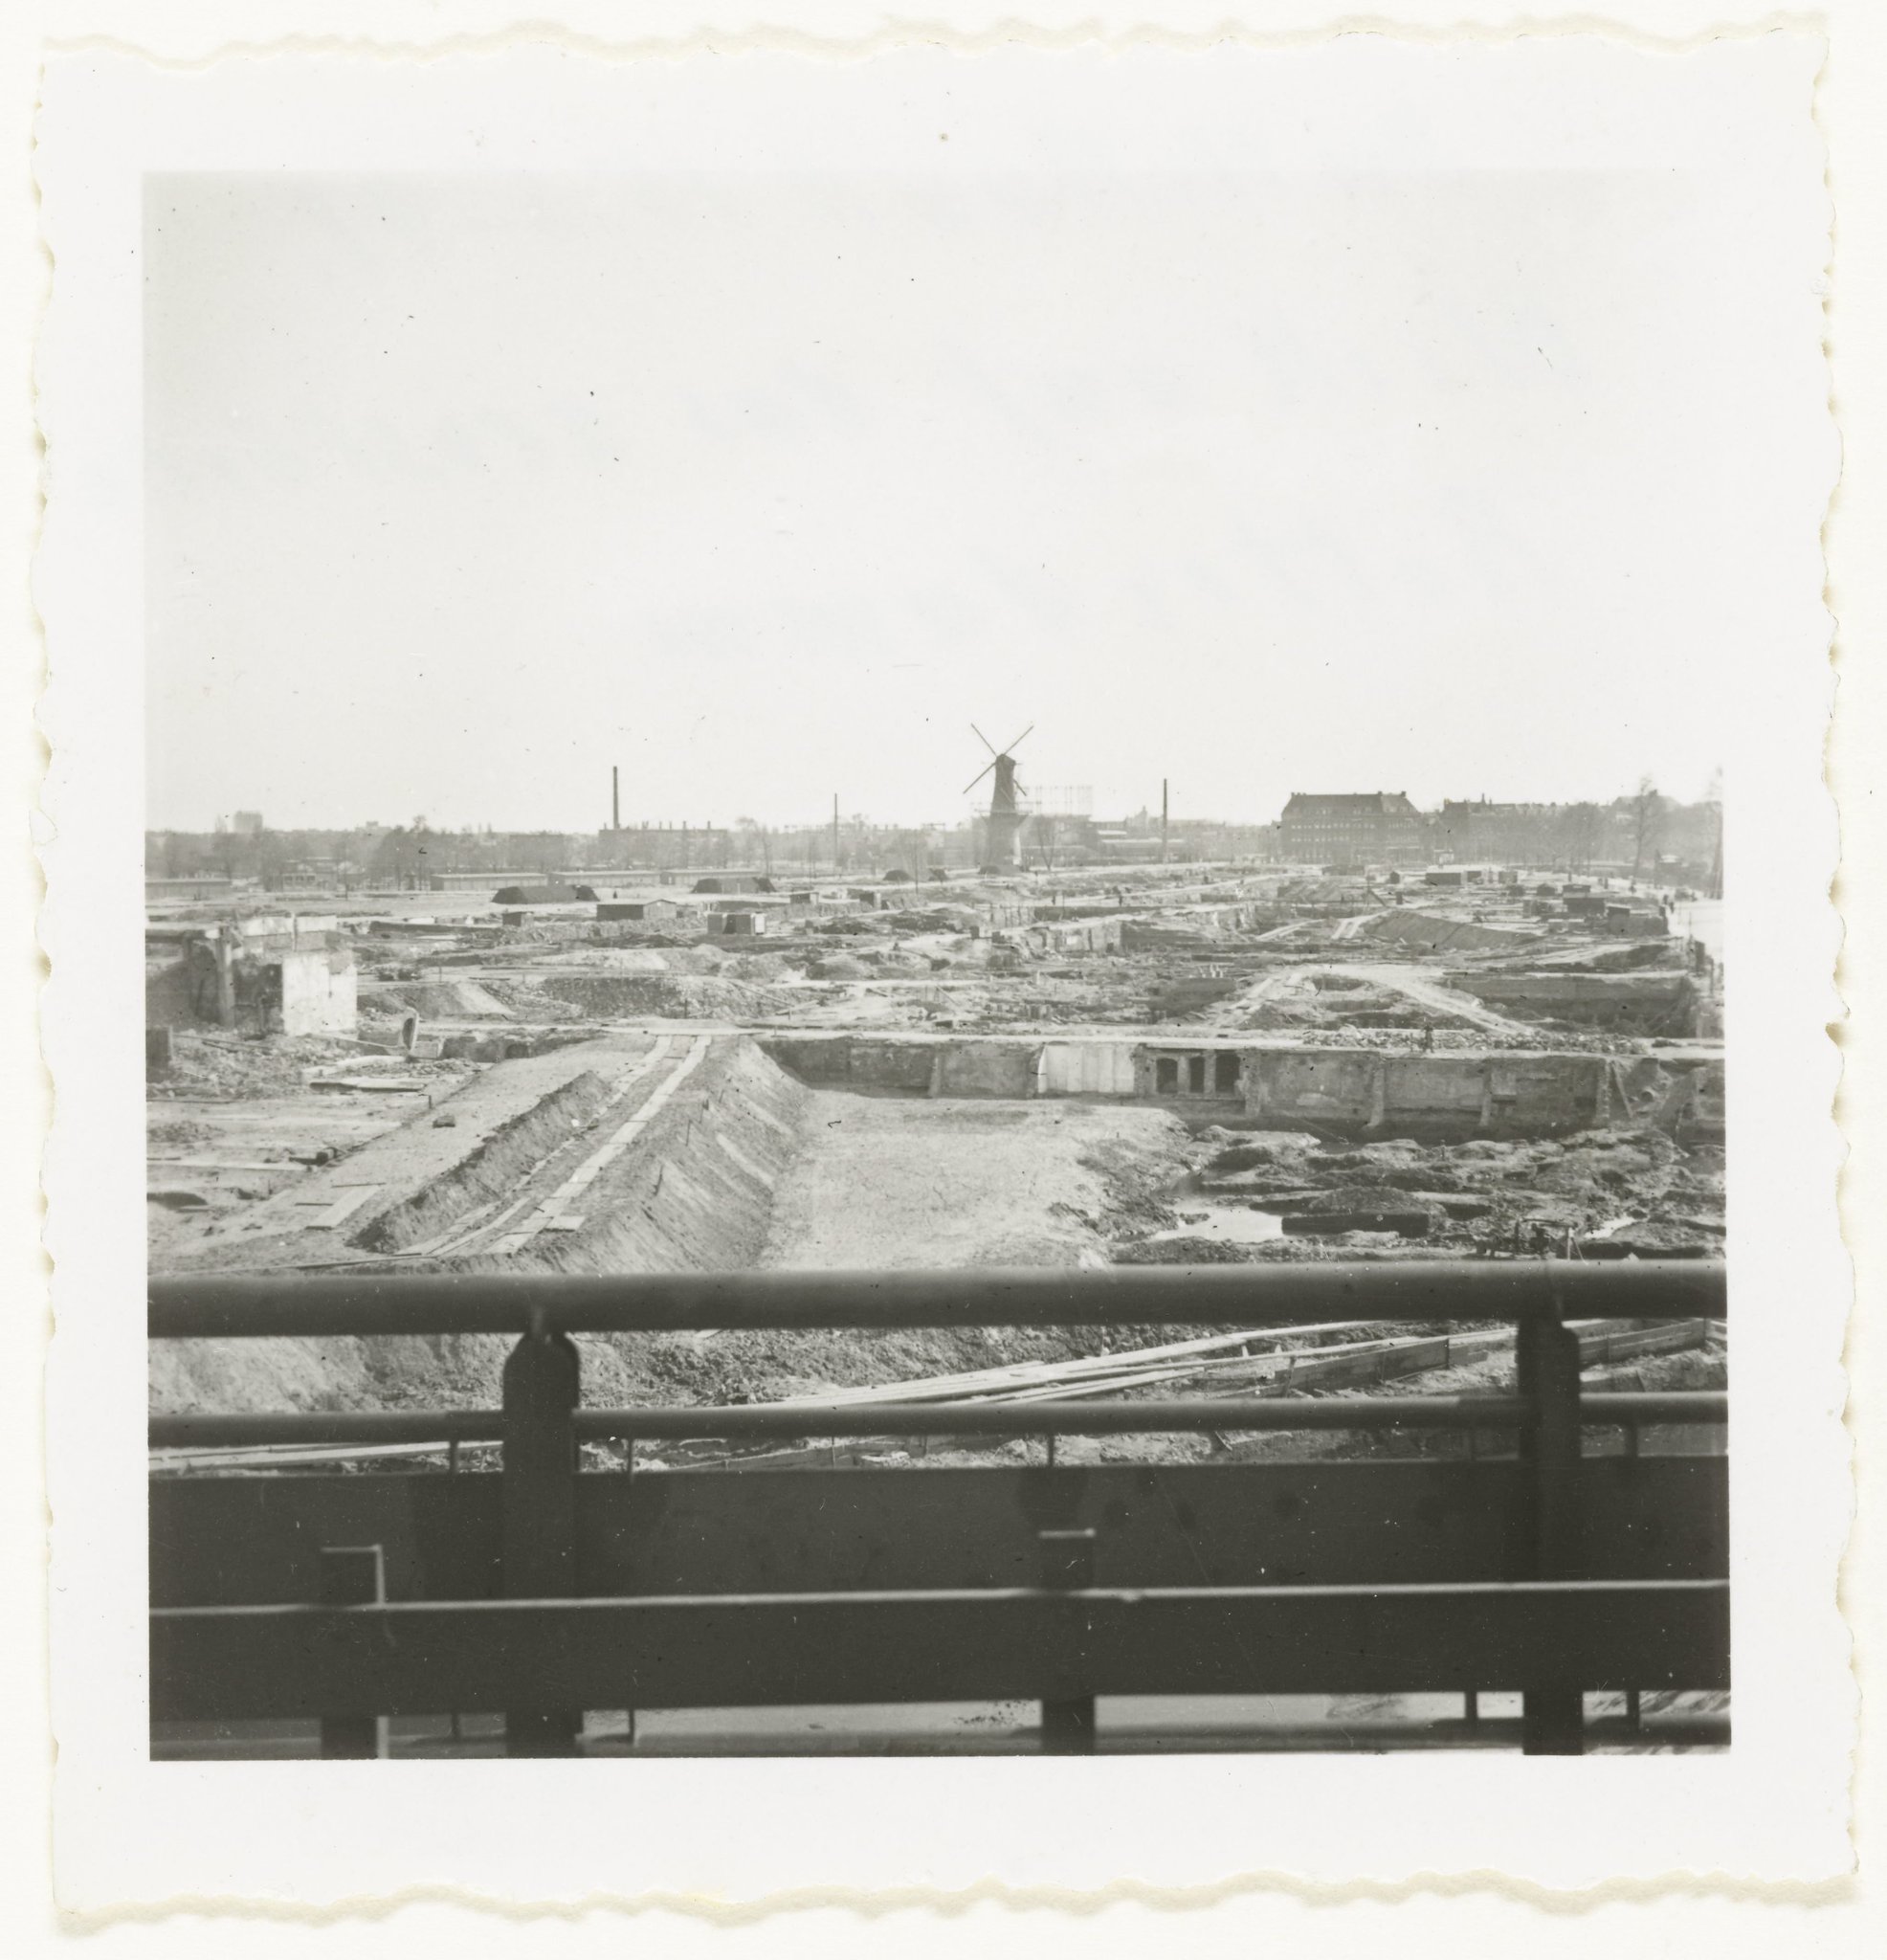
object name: photograph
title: Rotterdam een jaar na het bombardement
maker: Anonymous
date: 1941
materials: photographic support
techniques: gelatin silver print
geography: rotterdam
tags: devastated, ruined place or city (~ warfare), occupation ~ war, rotterdam, rotterdam blitz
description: Rotterdam een jaar na het bombardement. In de verte staat een molen. Achterop staat: In Holland. 15.5.41. Blick auf das zerstörte Rotterdam.